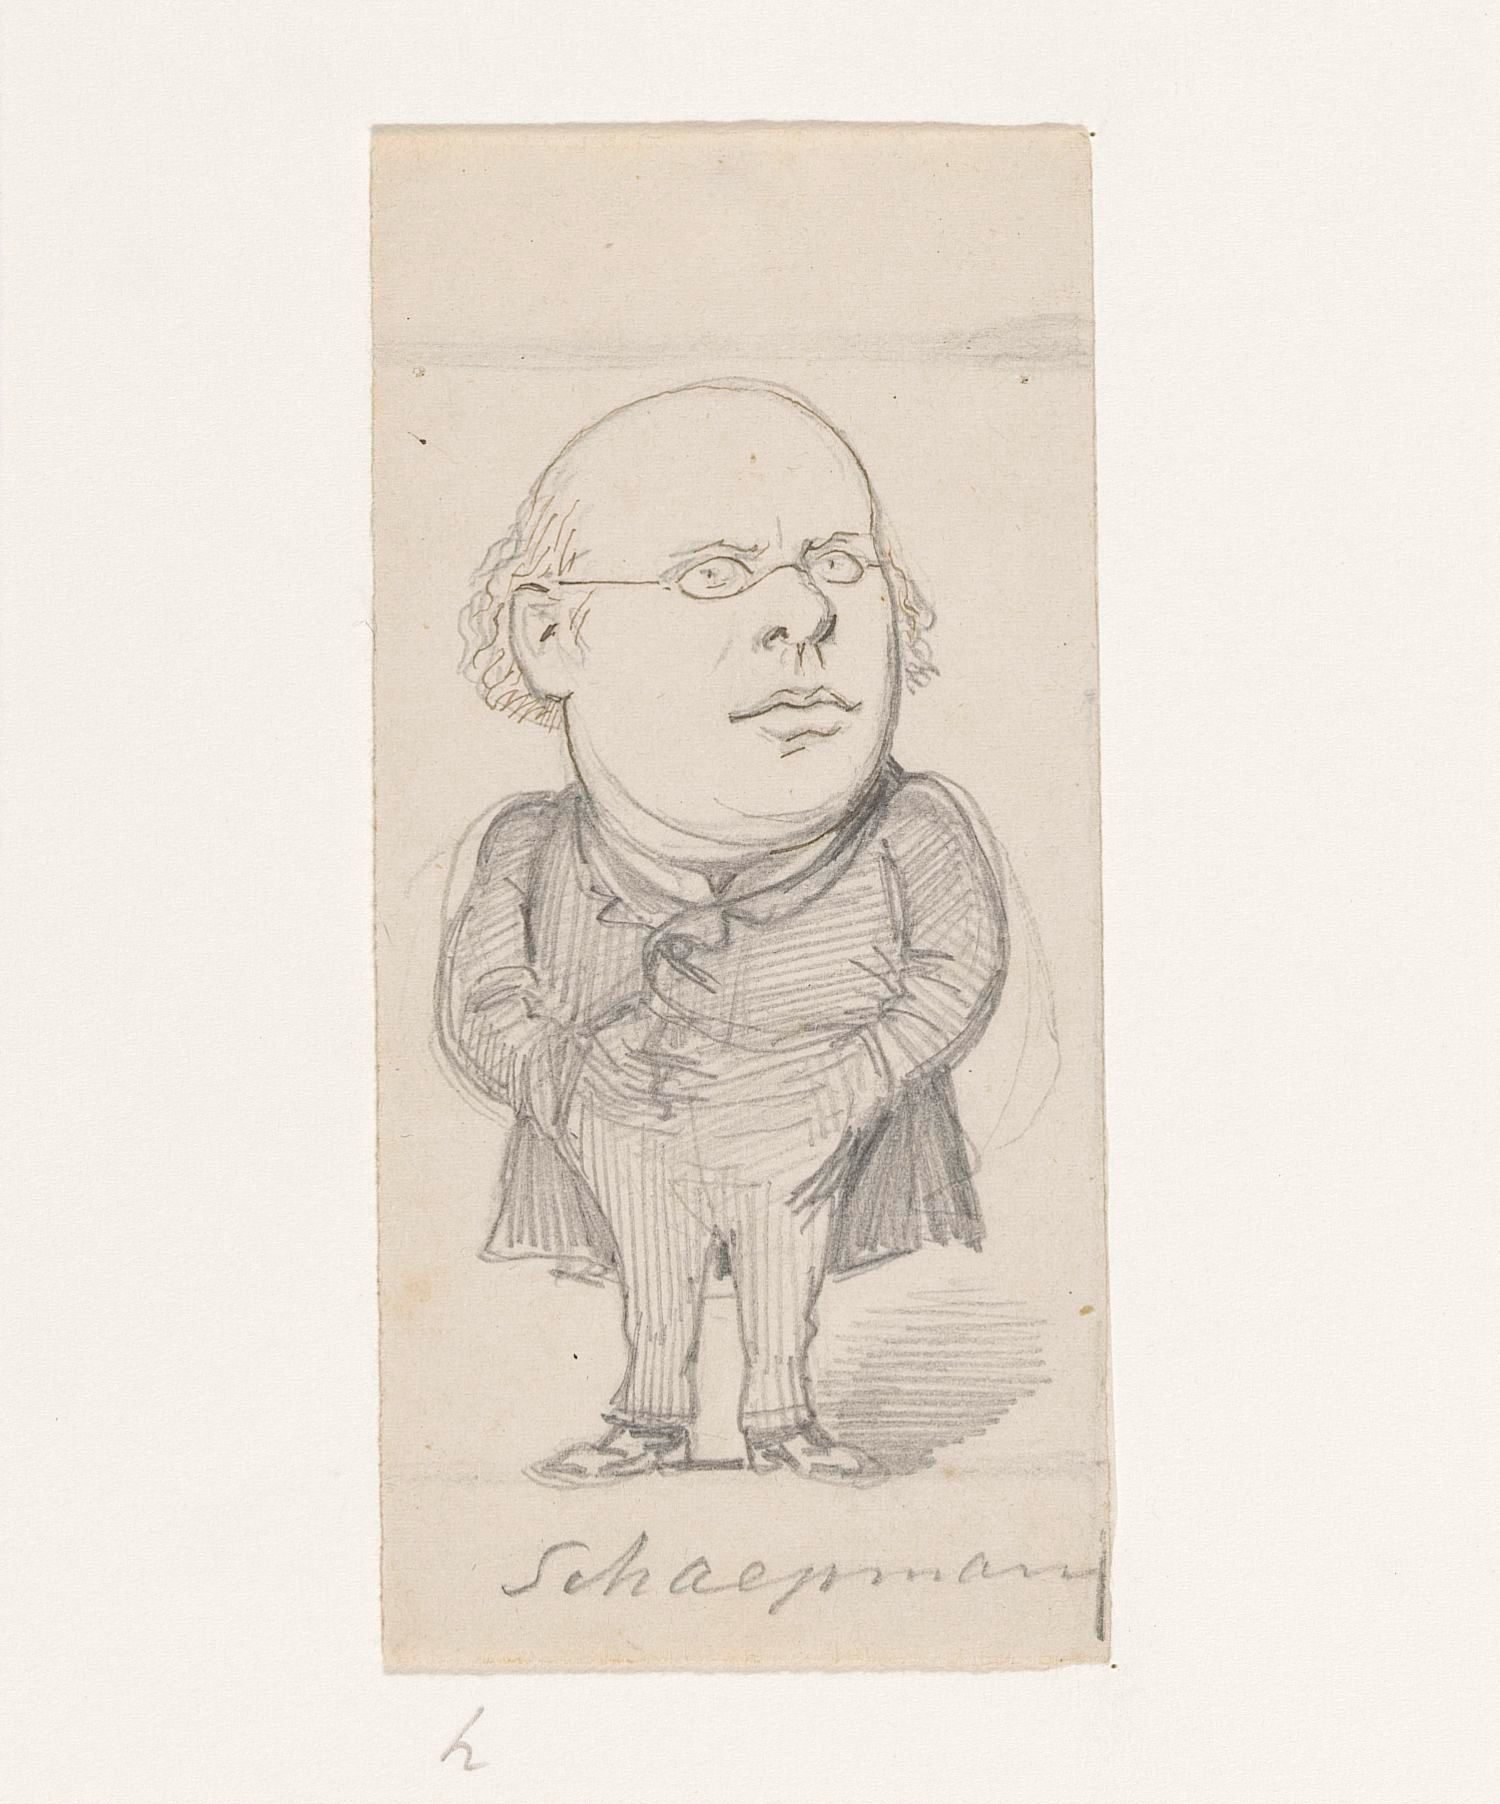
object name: preparatory study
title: Karikatuur van Herman Schaepman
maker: johan michaël schmidt crans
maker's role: draughtsman, print maker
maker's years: 1830-1907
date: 1886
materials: ink, paper, pencil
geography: netherlands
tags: rome, priest, herman johannes aloysius maria schaepman, historical persons, politician, e.g. party leader, netherlands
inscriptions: inscription: ‘Schaepman’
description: Karikatuur van de politicus dr. Herman Schaepman. Voorstudie voor een politieke spotprent in De Uilenspiegel 1886, p. 46.